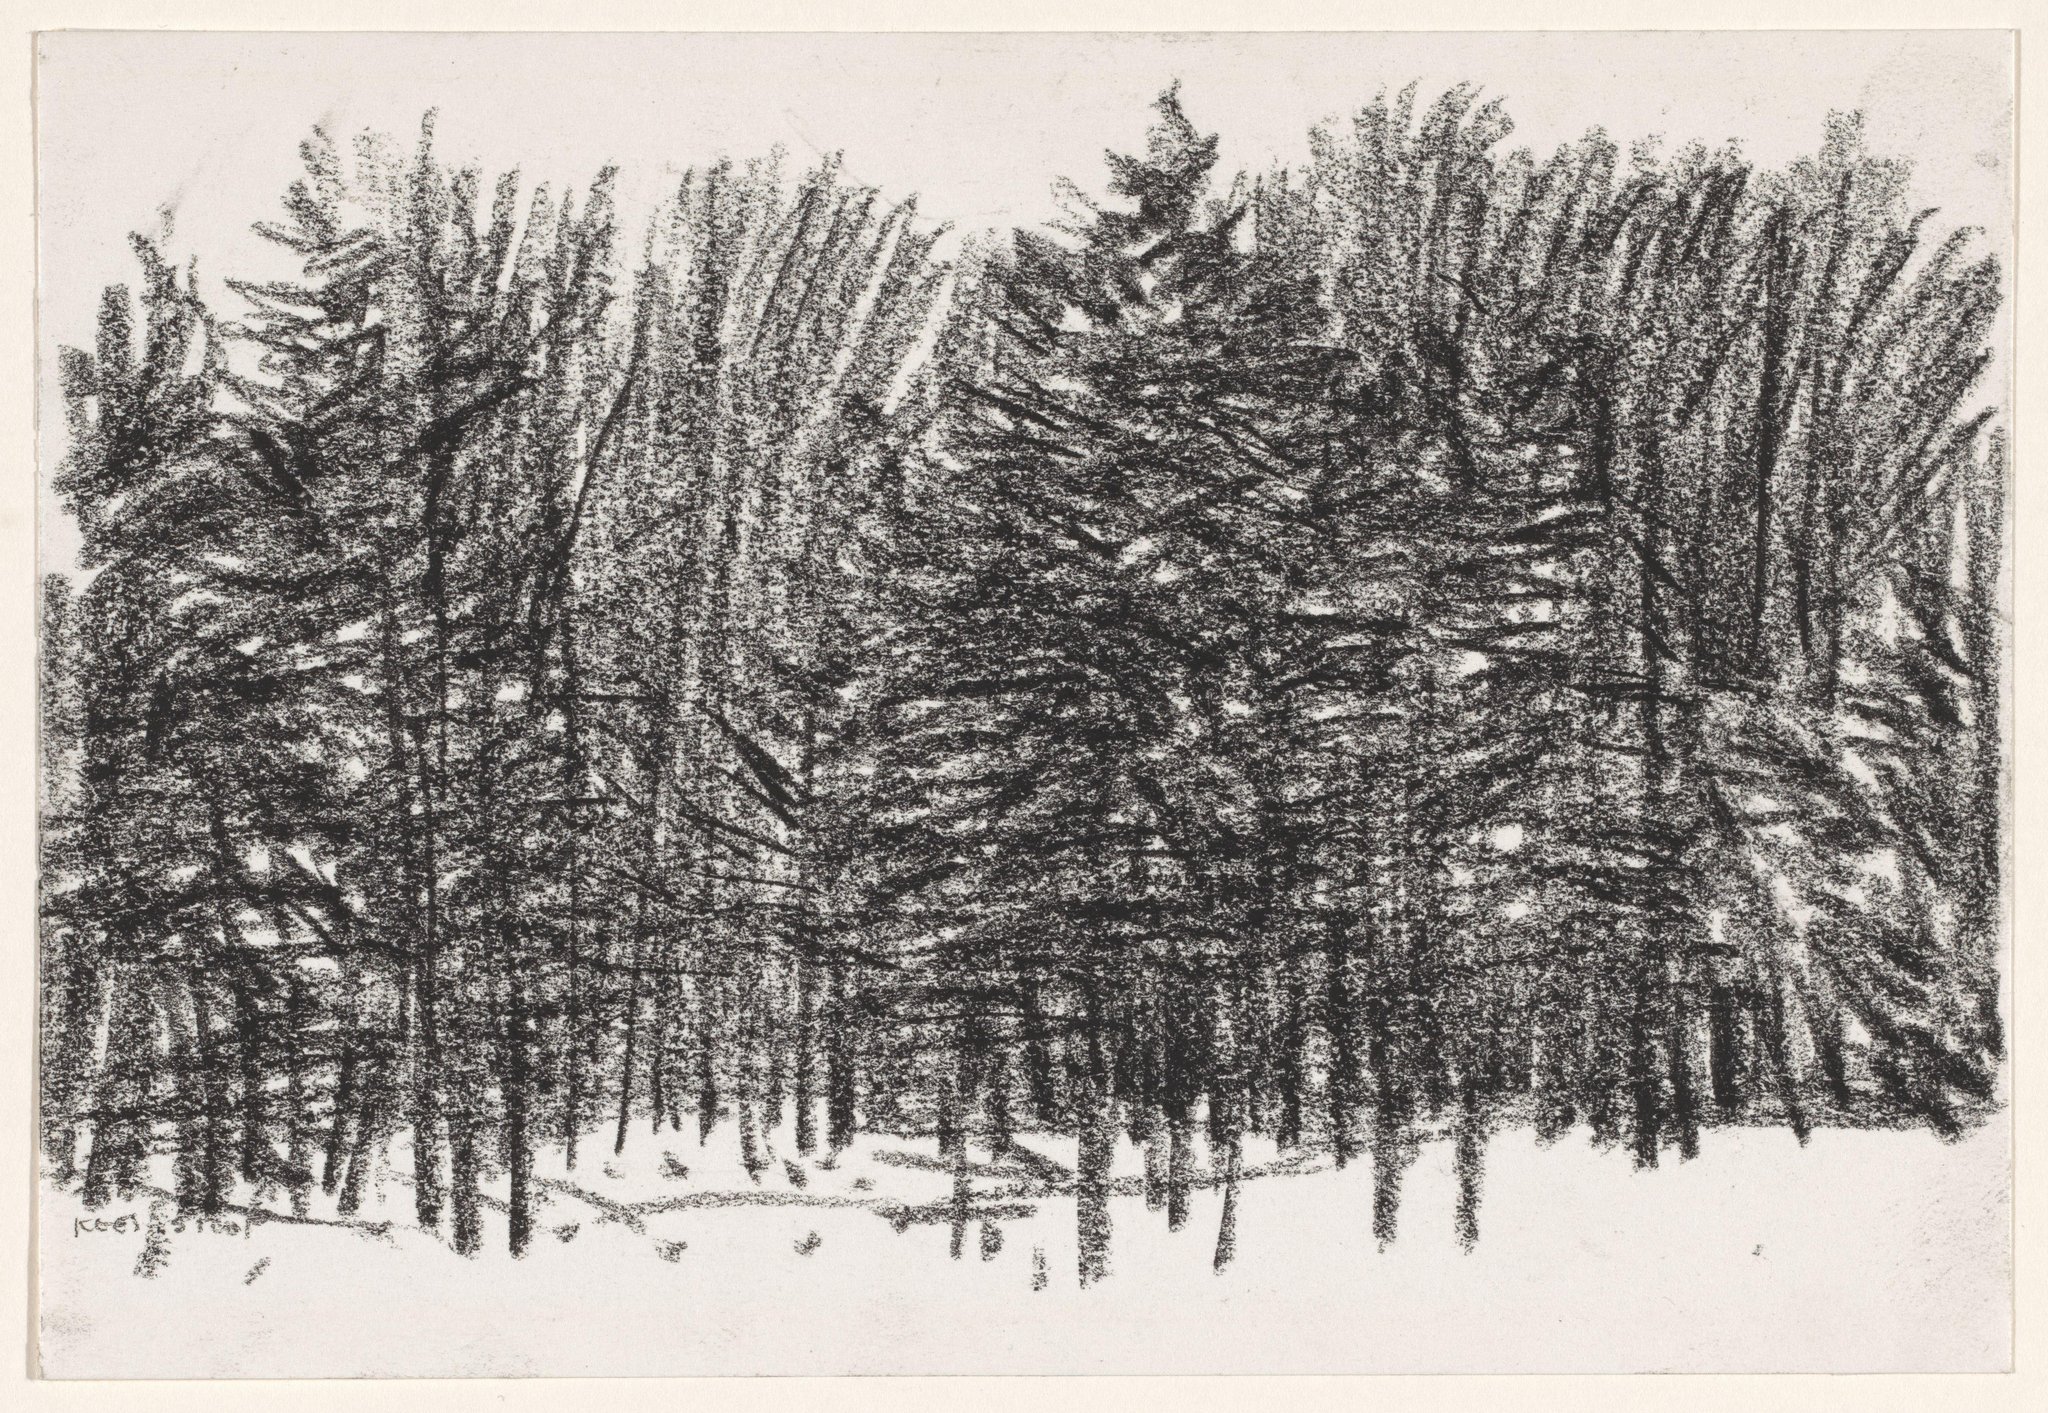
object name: drawing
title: Bosrand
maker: kees stoop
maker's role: draughtsman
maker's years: 1929-2019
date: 1939-2009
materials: charcoal, paper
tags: forest, wood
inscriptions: signature: ‘Kees Stoop’